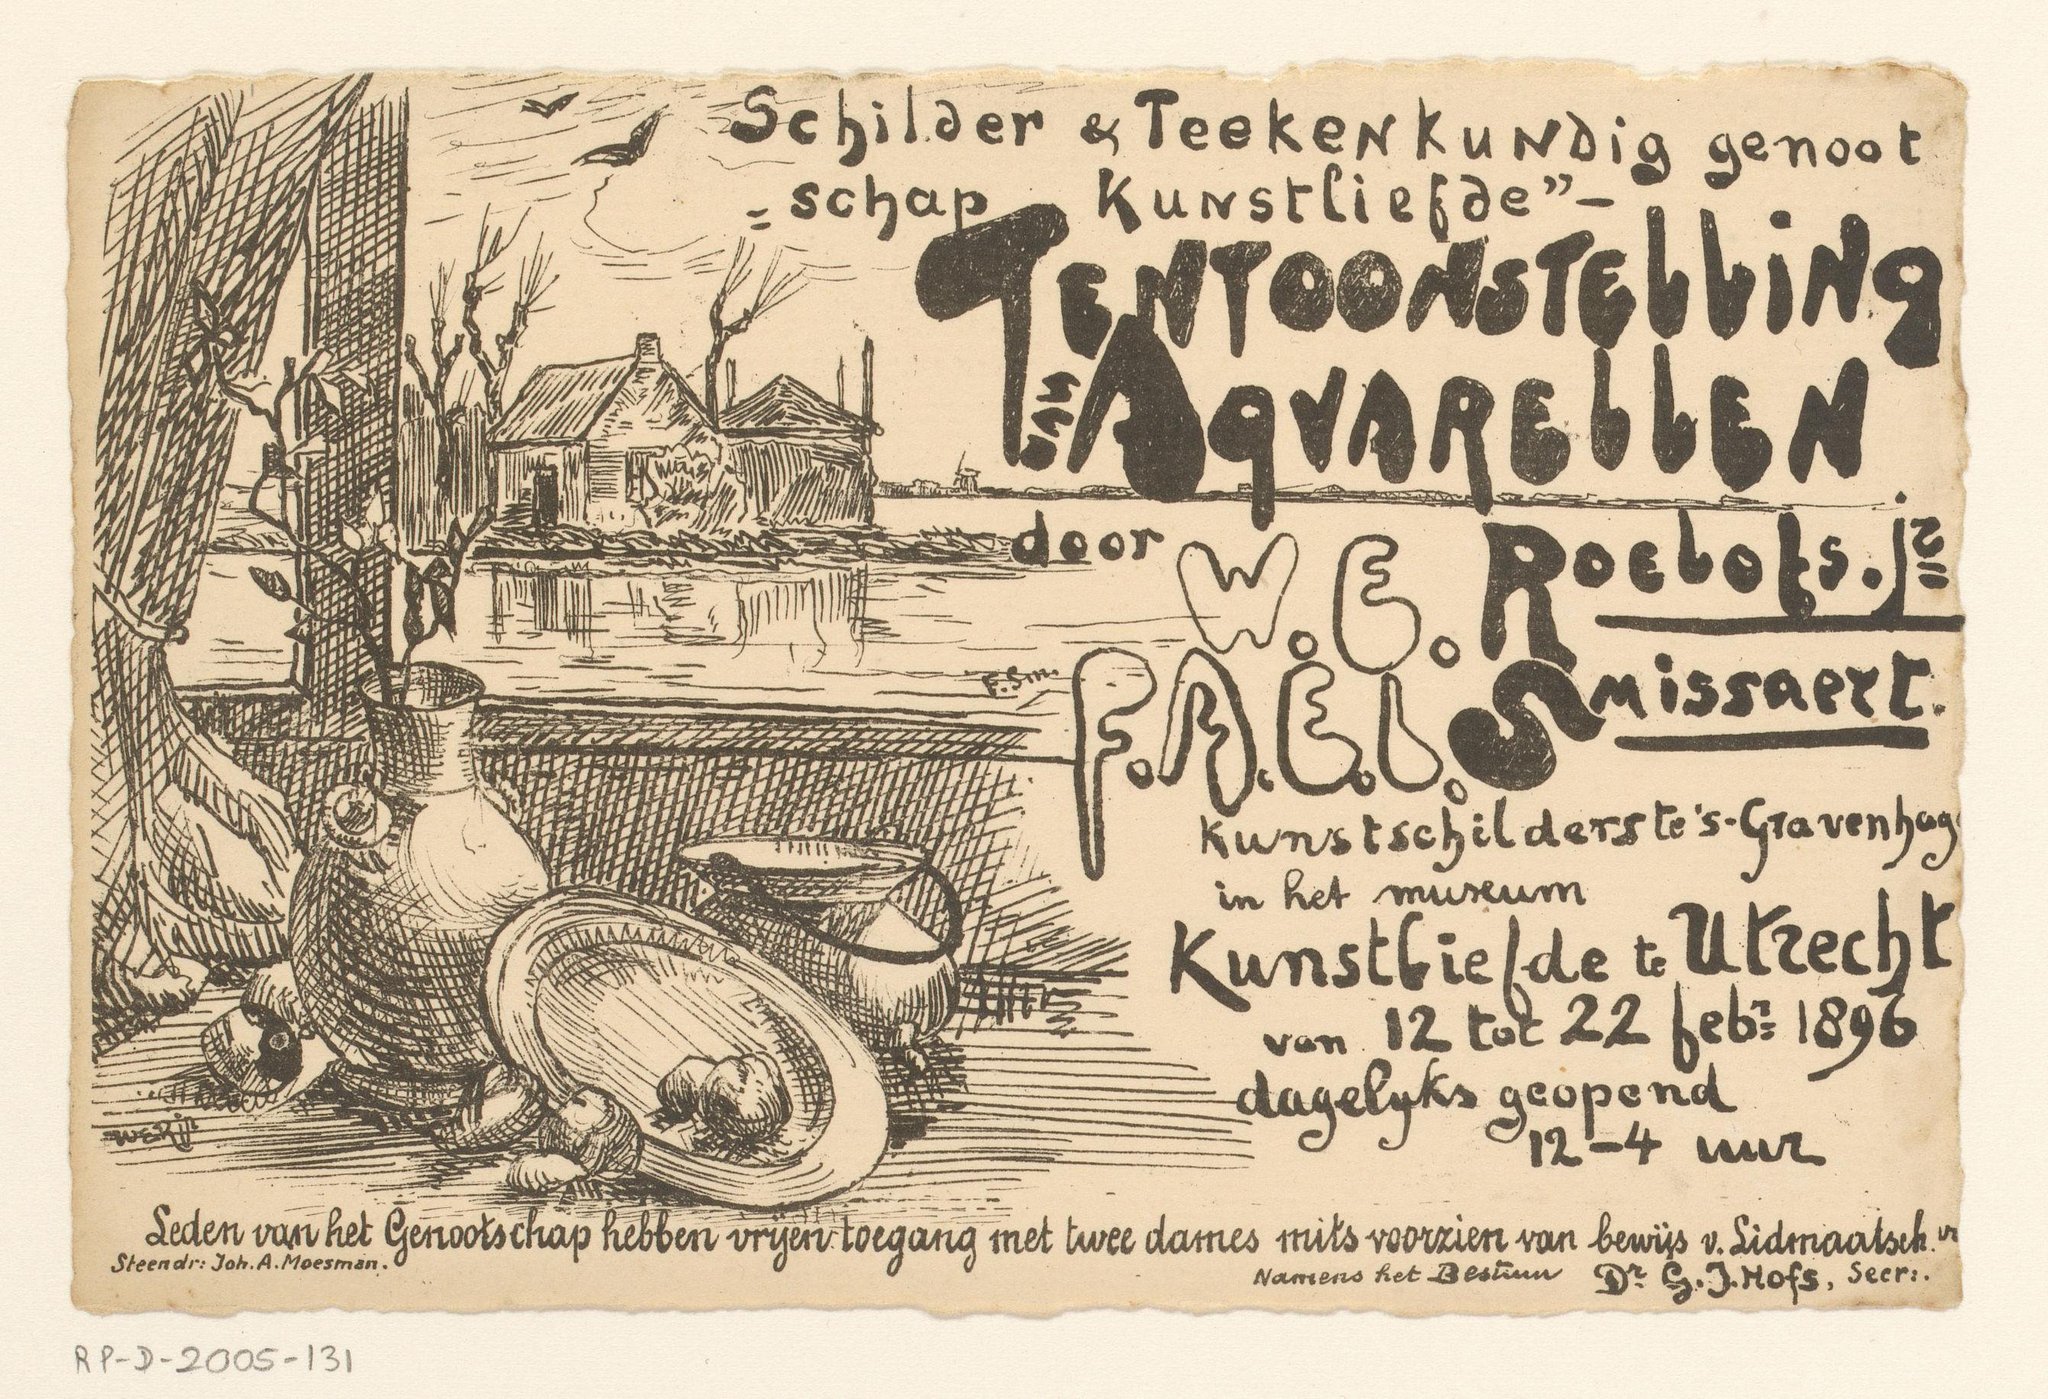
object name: print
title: Uitnodiging van Schilder- en Teekenkundig Genootschap "Kunstliefde" voor een tentoonstelling van aquarellen, 12-22 februari 1896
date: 1802-1896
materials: paper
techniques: lithograph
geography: utrecht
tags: the hague, painter, print maker, draughtsman, willem roelofs (ii), frans smissaert, criticizing and discussing art, art criticism, circle, club of artists, collecting and exhibiting products of the fine arts, canals, waters (in village), still life of related objects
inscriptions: collector's mark: Lugt 2228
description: Stilleven van potten en vaas voor een raam met uitzicht op een boerderij aan het water. Uitnodiging van Schilder- en Teekenkundig Genootschap "Kunstliefde" voor een tentoonstelling van aquarellen van Willem Roelofs jr. en Frans Smissaert, kunstschilders te Den Haag in het museum Kunstliefde te Utrecht, 12-22 februari 1896.